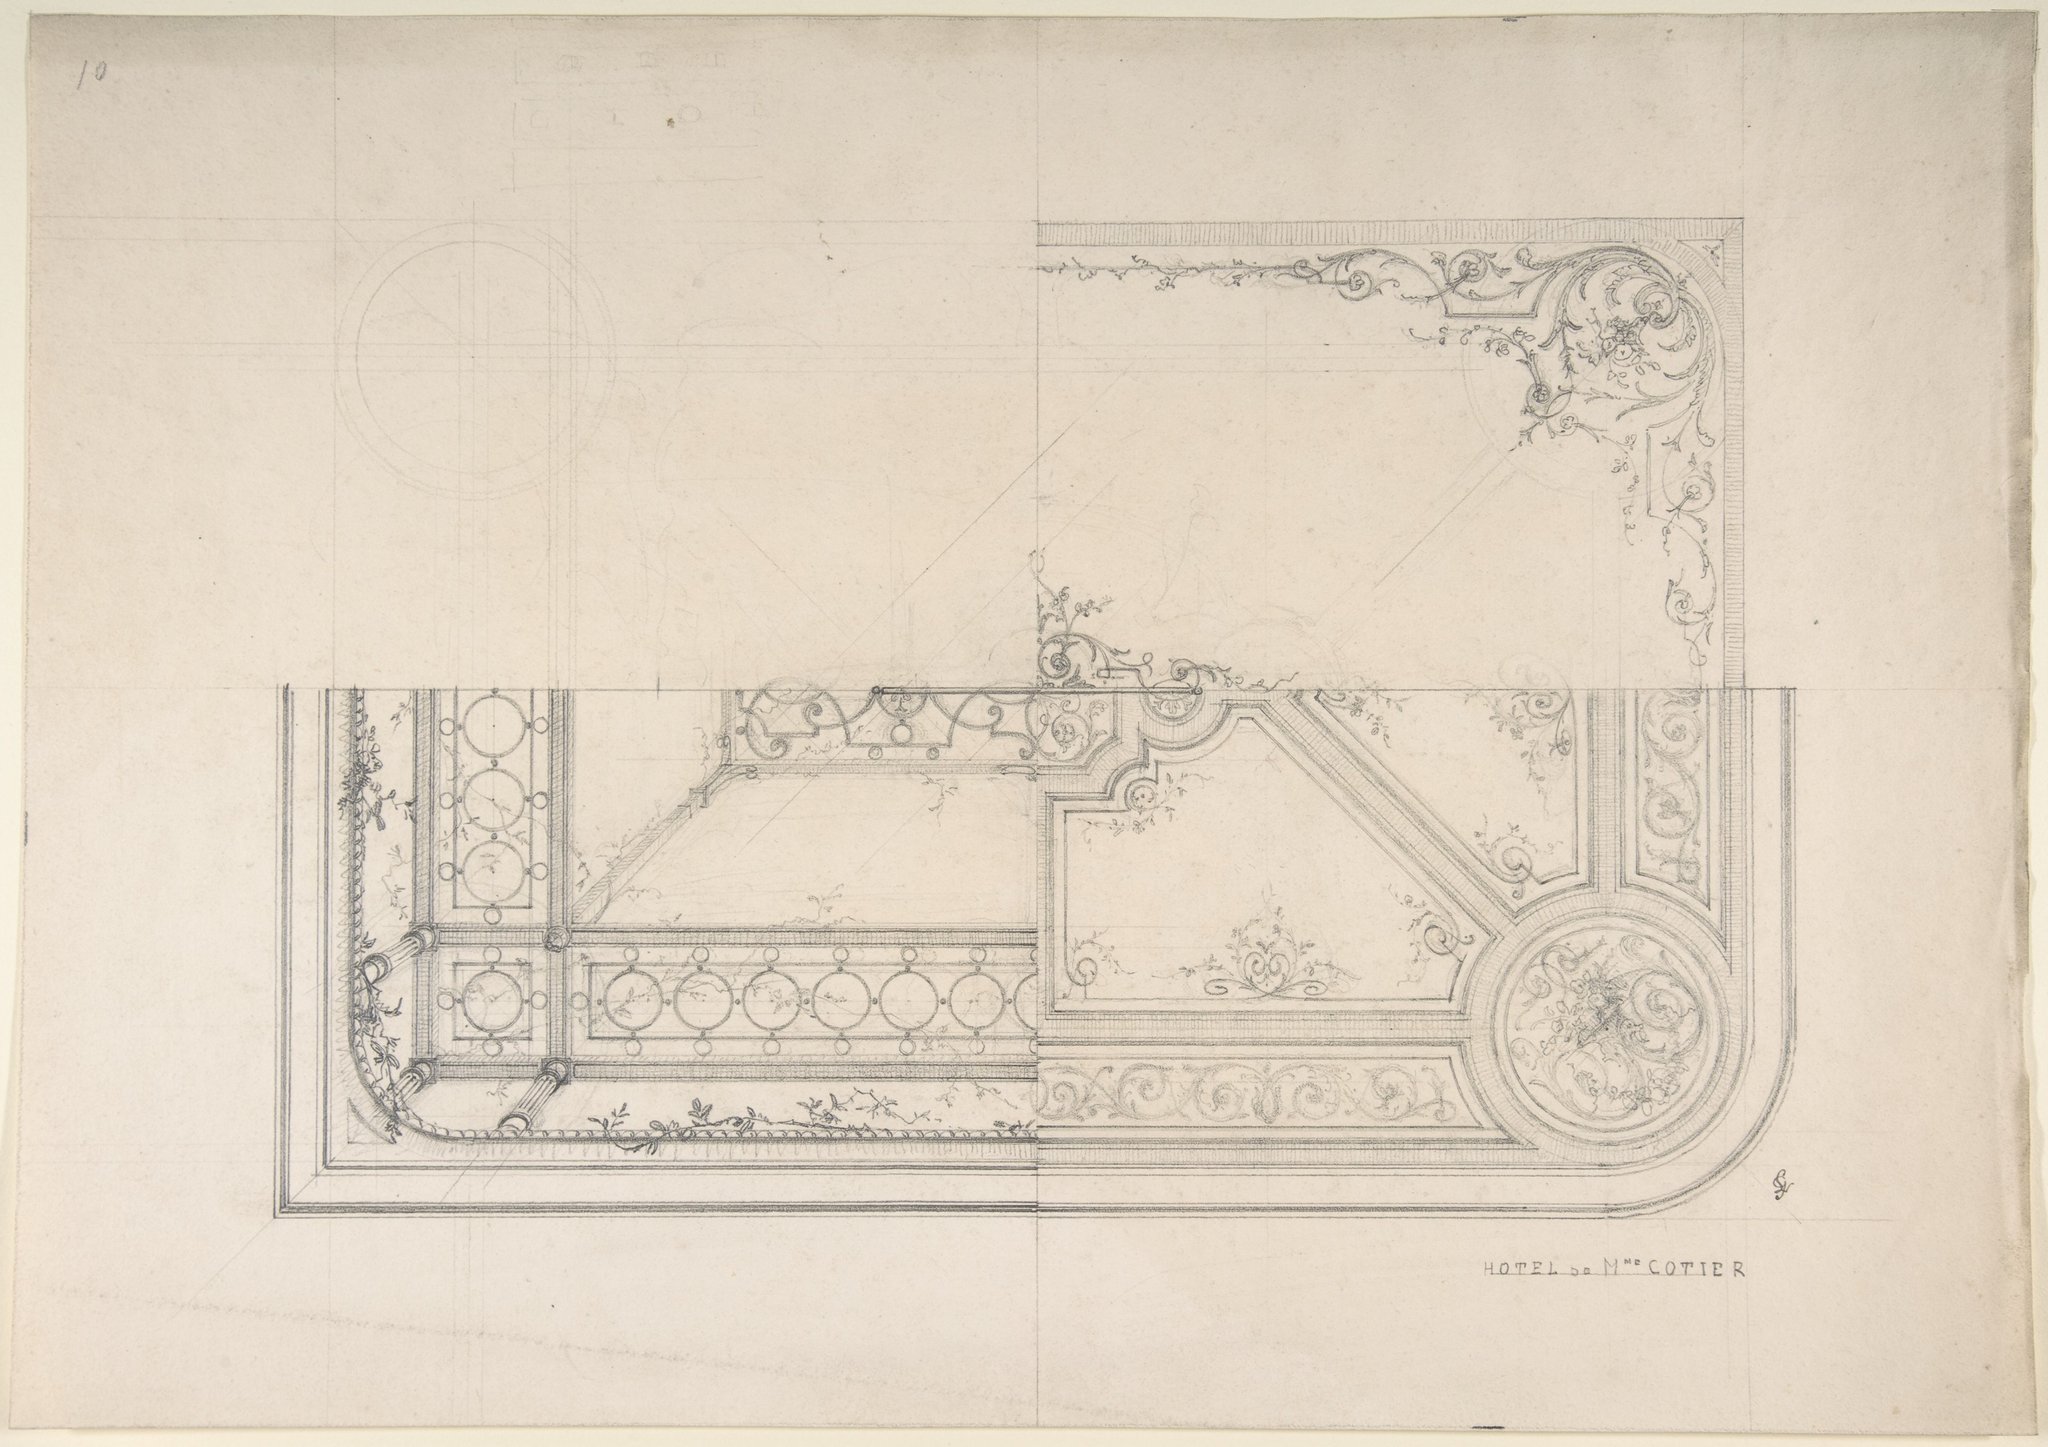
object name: drawing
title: Three Designs for Ceilings, Hôtel Cottier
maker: jules-edmond-charles lachaise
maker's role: artist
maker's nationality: french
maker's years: 1897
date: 1879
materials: graphite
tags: ornament